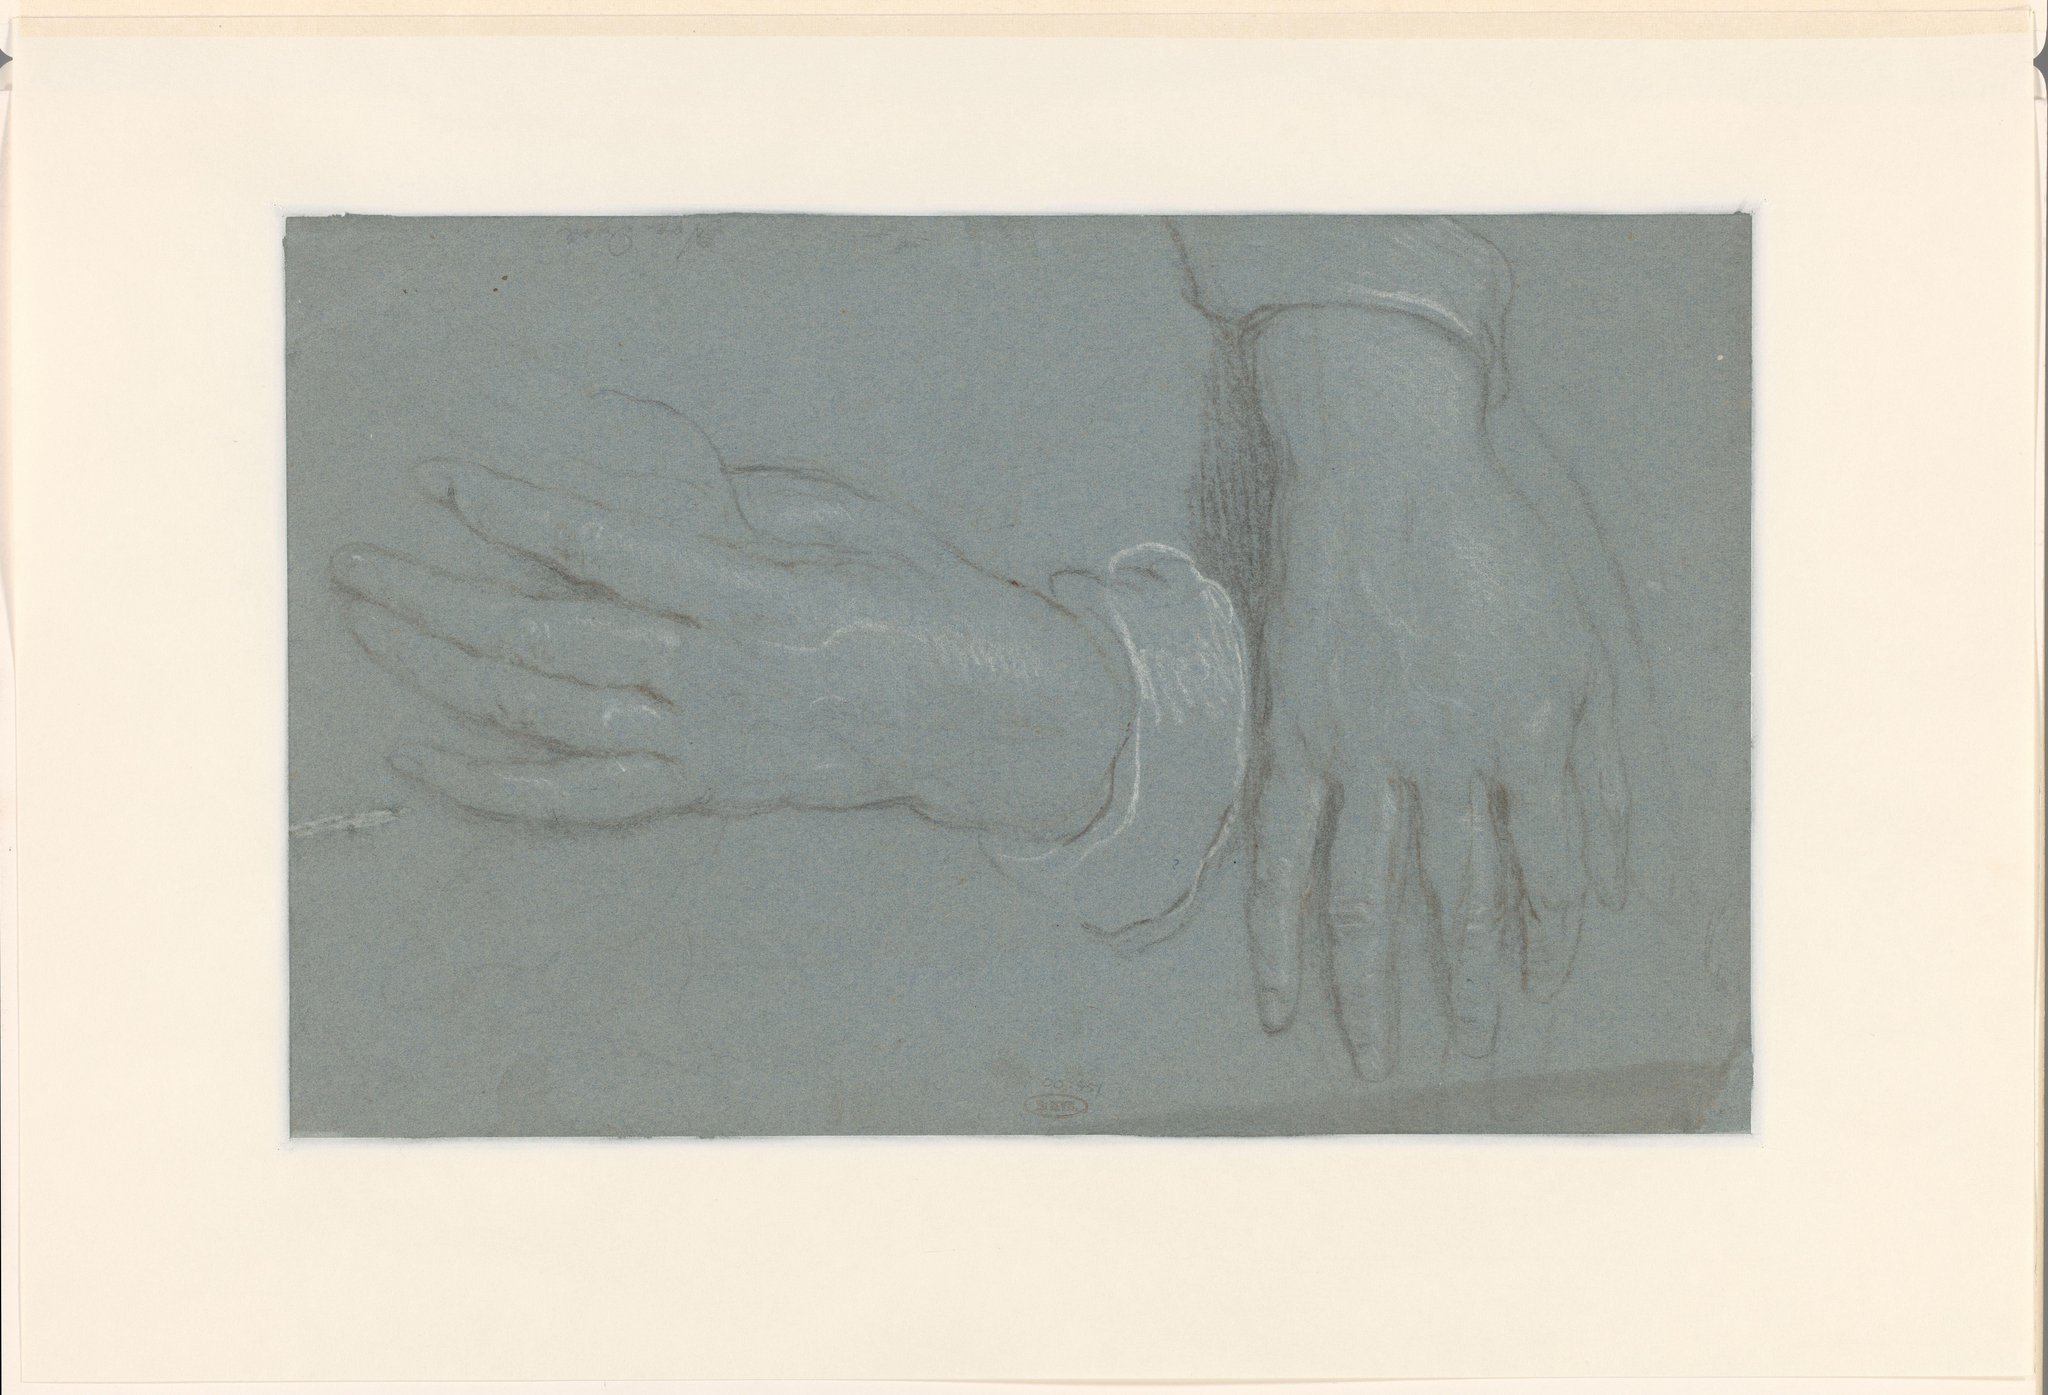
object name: drawing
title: Studie van twee vlak liggende handen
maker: anthony van dyck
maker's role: draughtsman, painter, print maker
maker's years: 1599-1641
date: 1610-1641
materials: chalk, paper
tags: hand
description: Afkomstig uit een tekeningenalbum met onder andere figuur- en handstudies van of naar Caspar en Constantijn Netscher (BI-1894-3720). Tekening bevond zich oorspronkelijk op f. 29.